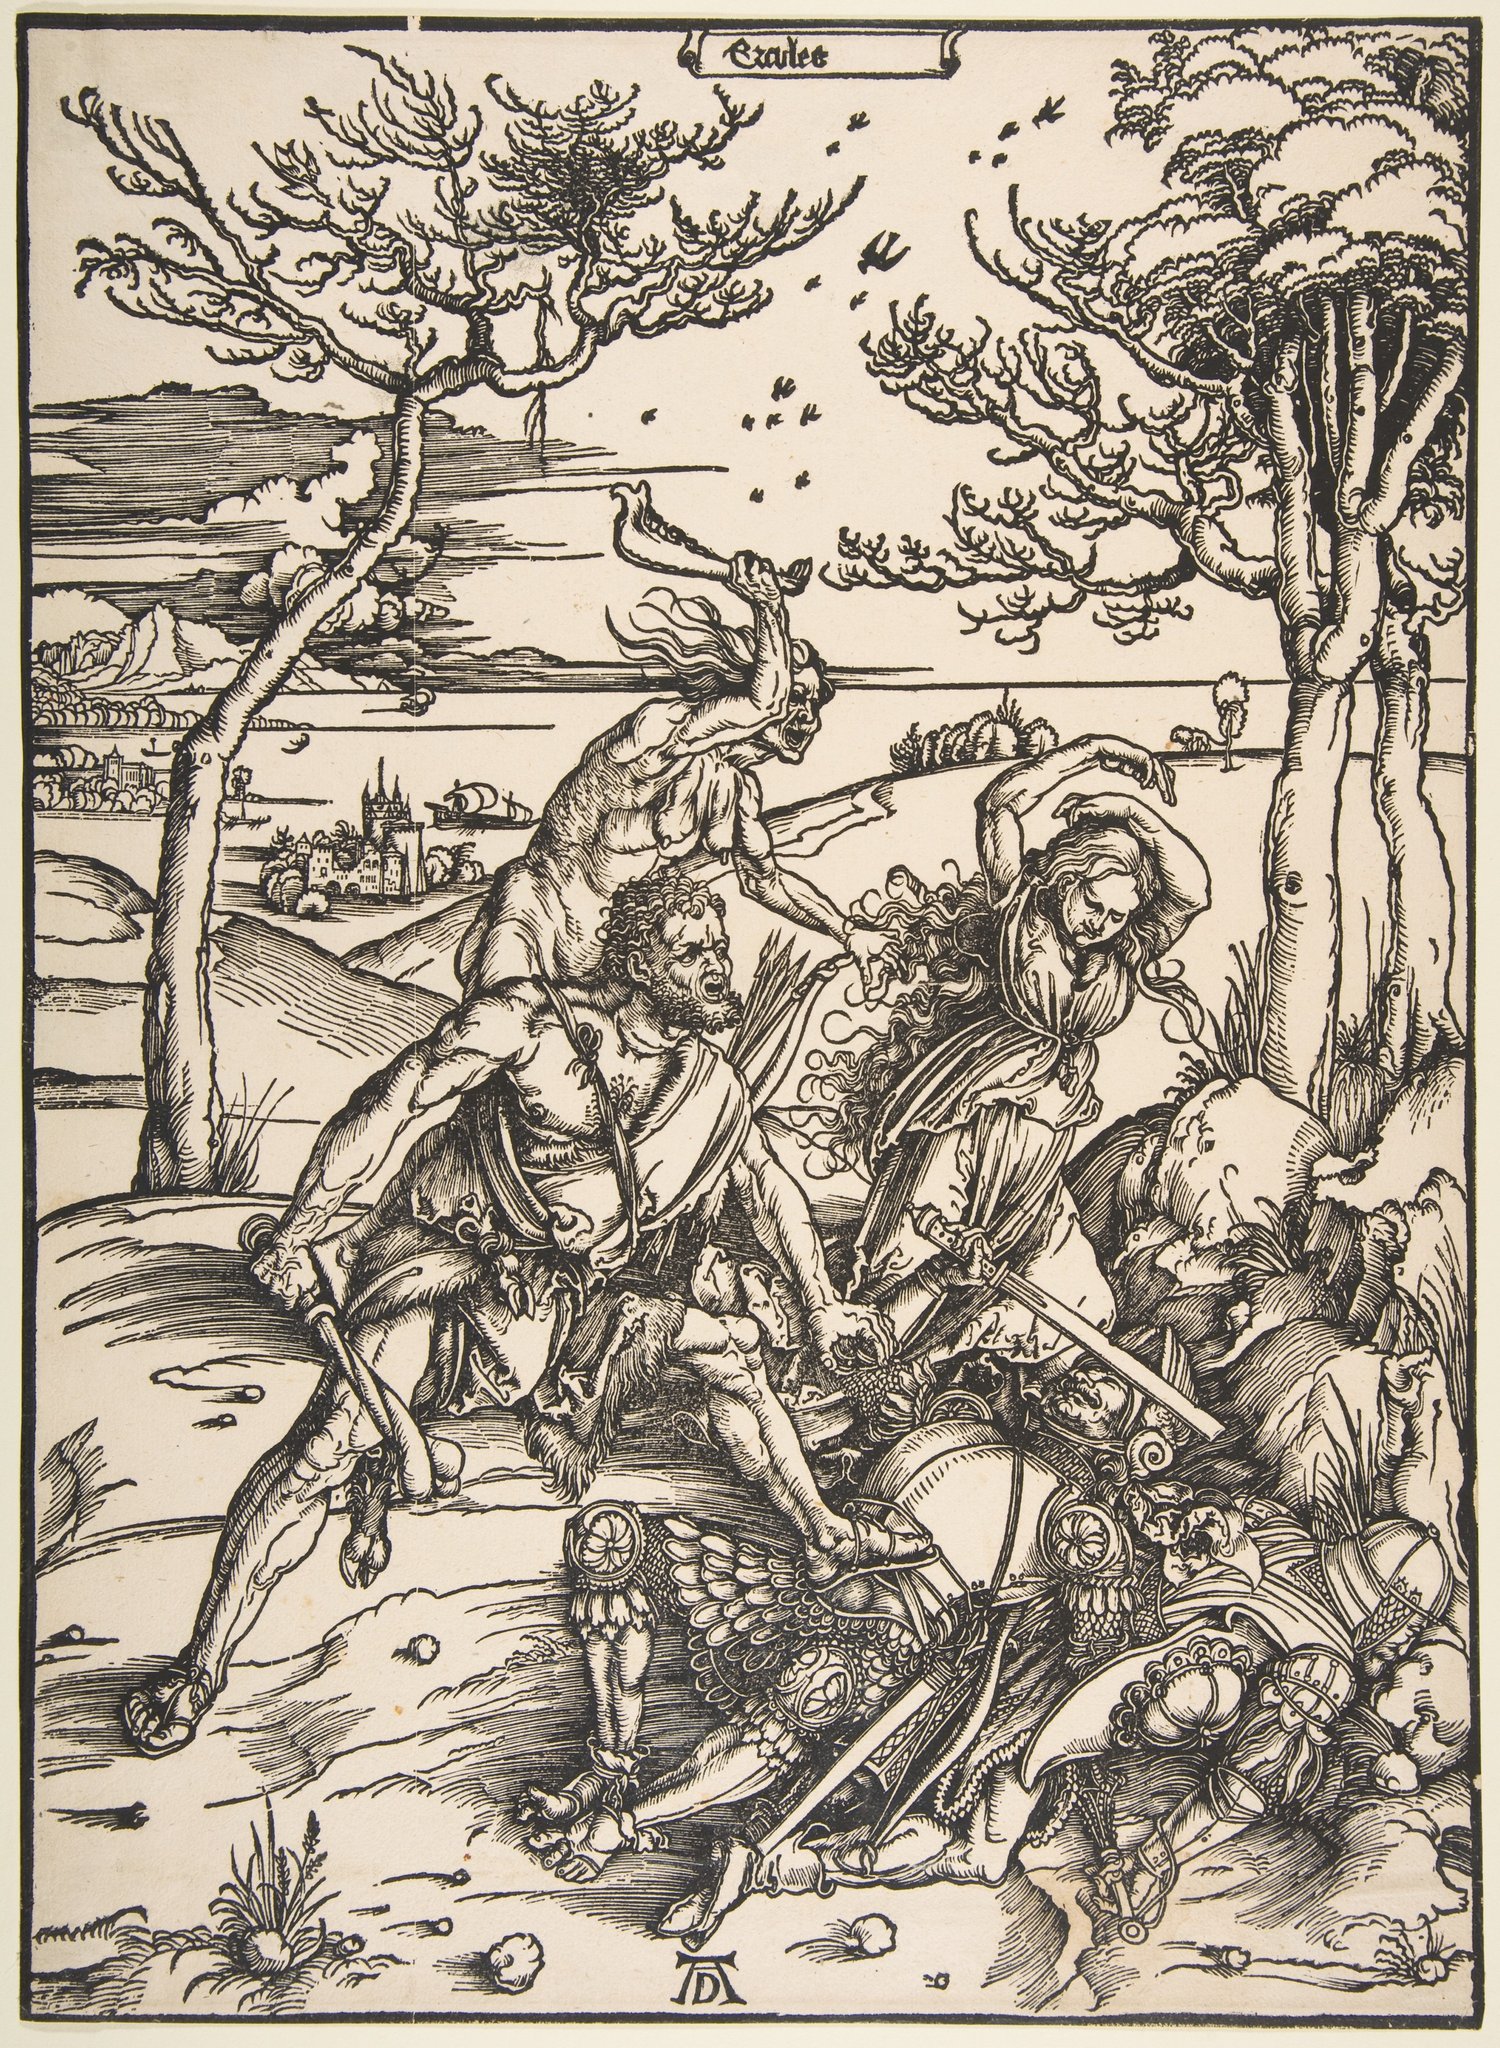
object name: print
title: Hercules and Cacus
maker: albrecht dürer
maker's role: artist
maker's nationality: german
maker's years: 1471-1528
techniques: woodcut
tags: soldiers,women,hercules